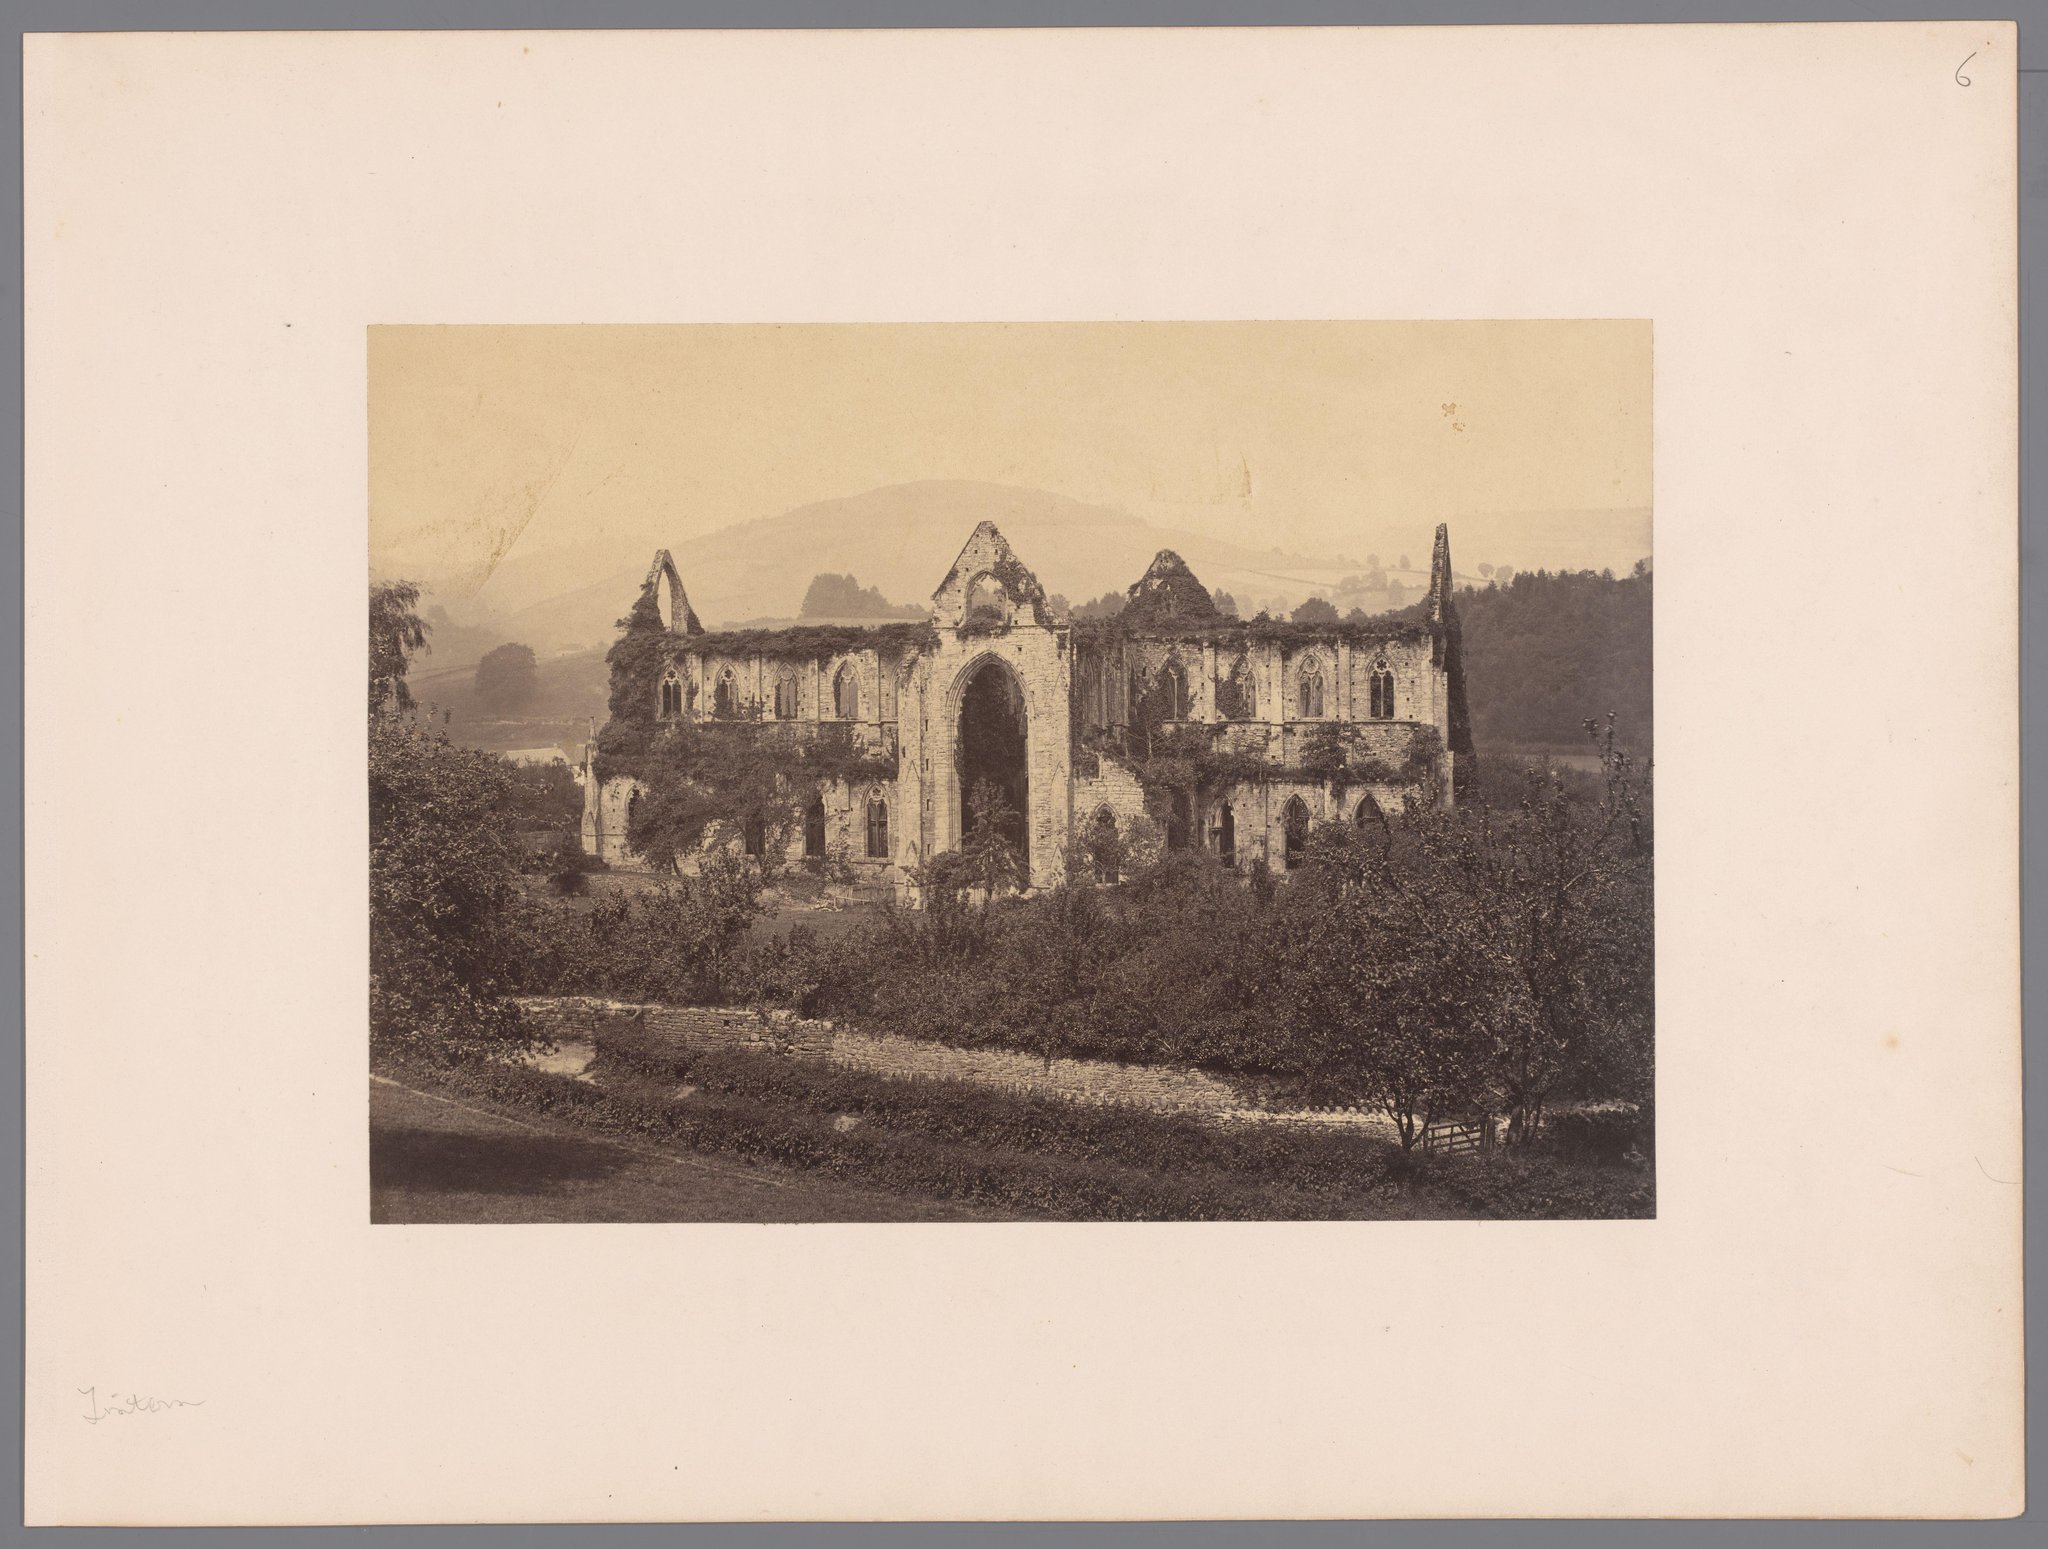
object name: photograph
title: Tintern Abbey, Wales, Engeland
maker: Anonymous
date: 1870-1900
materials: cardboard, photographic support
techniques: albumen print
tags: wales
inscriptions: number: ‘6’, caption: ‘Lintern [?]’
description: Klooster opgericht door Walter de Clare, Lord of Chepstow op 9 mei 1131. Gelegen aan de rivier Wye in Monmouthshire, Engeland.